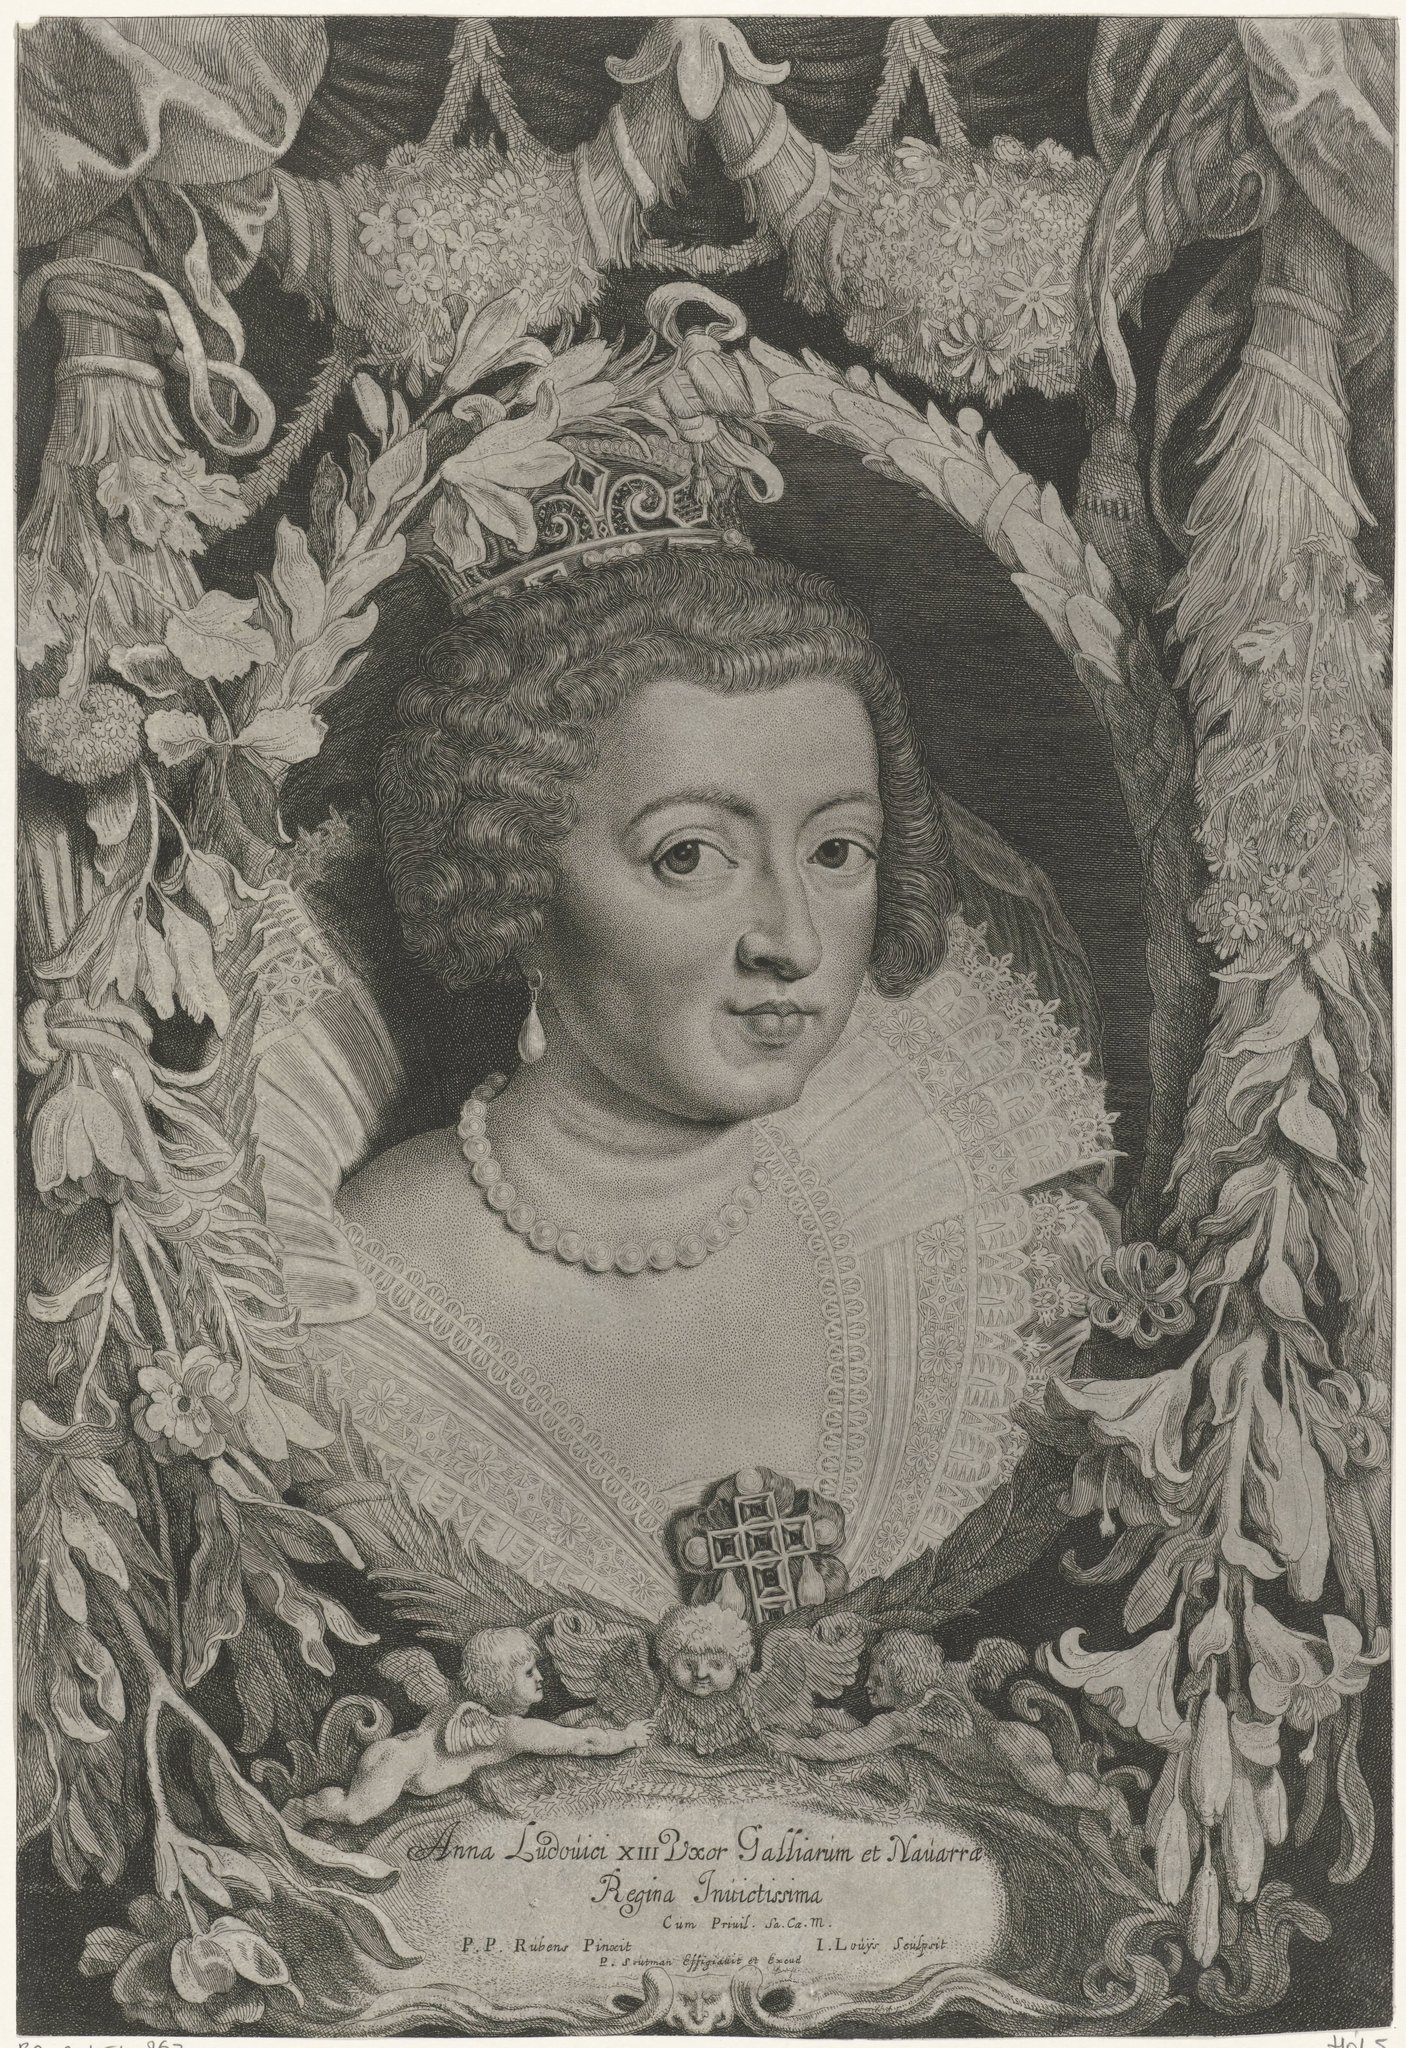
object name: print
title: Portret van Anna van Oostenrijk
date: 1644-1650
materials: paper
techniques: engraving, etching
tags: paris, anna van oostenrijk (koningin van frankrijk)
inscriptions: collector's mark: Lugt 2760, collector's mark: Lugt 2228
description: De prenten in de serie Ferdinandus II[us] et III[us] Imperatorum Domus Austriacae zijn vervaardigd door verschillende graveurs: Jonas Suyderhoef, Jacob Louys en Pieter van Sompel.